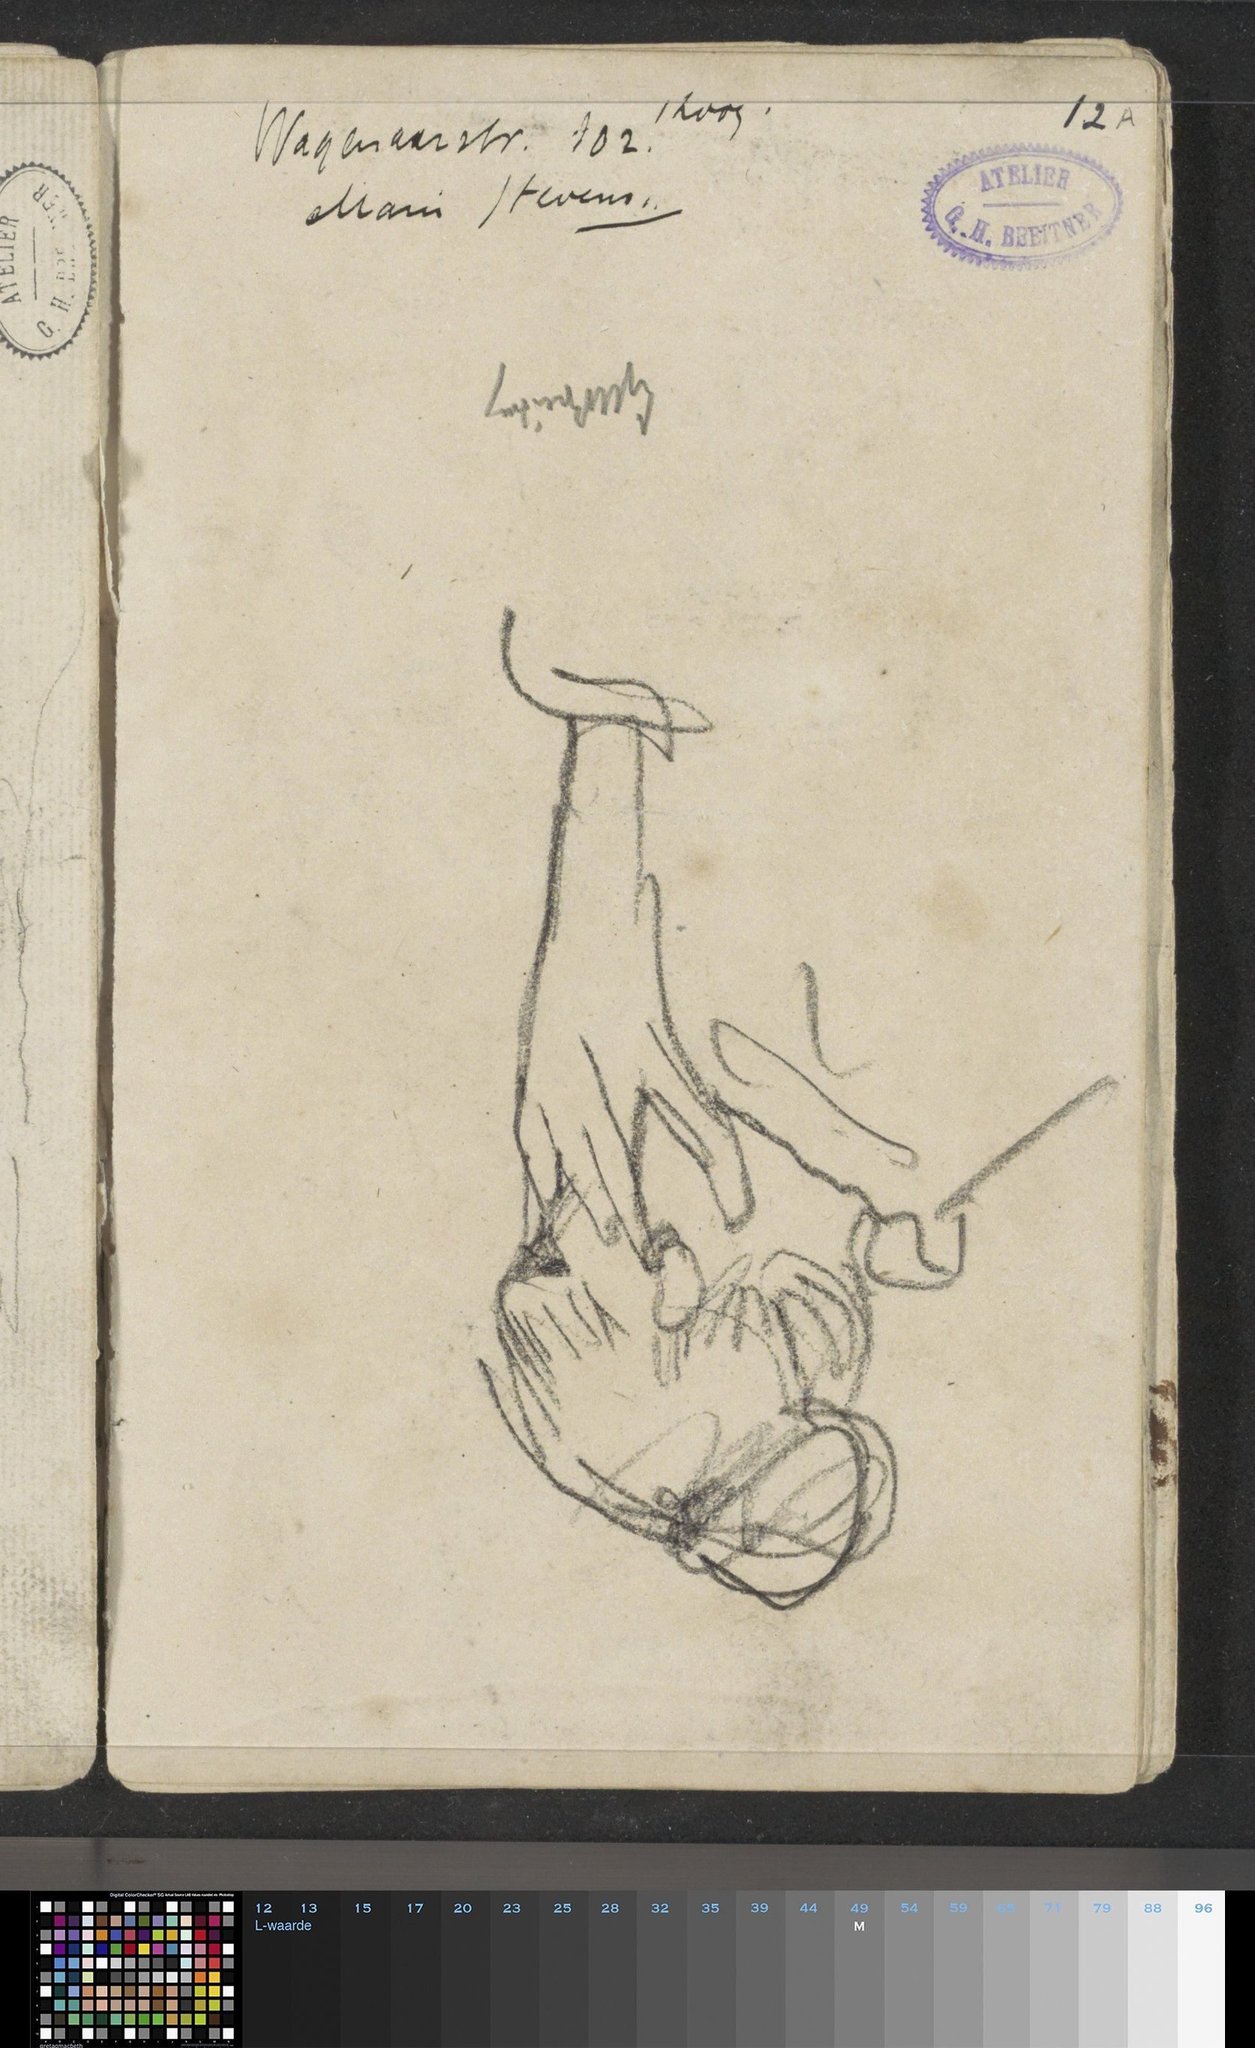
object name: sketchbook leaf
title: Vrouw met een hand bij haar gezicht, in profiel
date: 1880-1882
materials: chalk, paper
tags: hand(s) towards the ear(s), adult woman (+ sideview, profile)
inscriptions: annotation: ‘Wagenaarstr. 102 1 hoog/ Mani Stevens.’, workshop stamp: Lugt 291d, signature: ‘GHBreitner’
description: Blad 12A recto uit een schetsboek met 16 bladen.